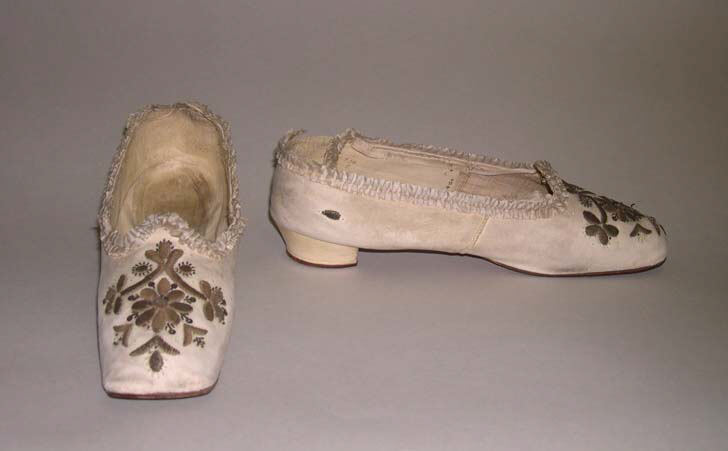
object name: pump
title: Pumps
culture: french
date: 1860-1869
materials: leather